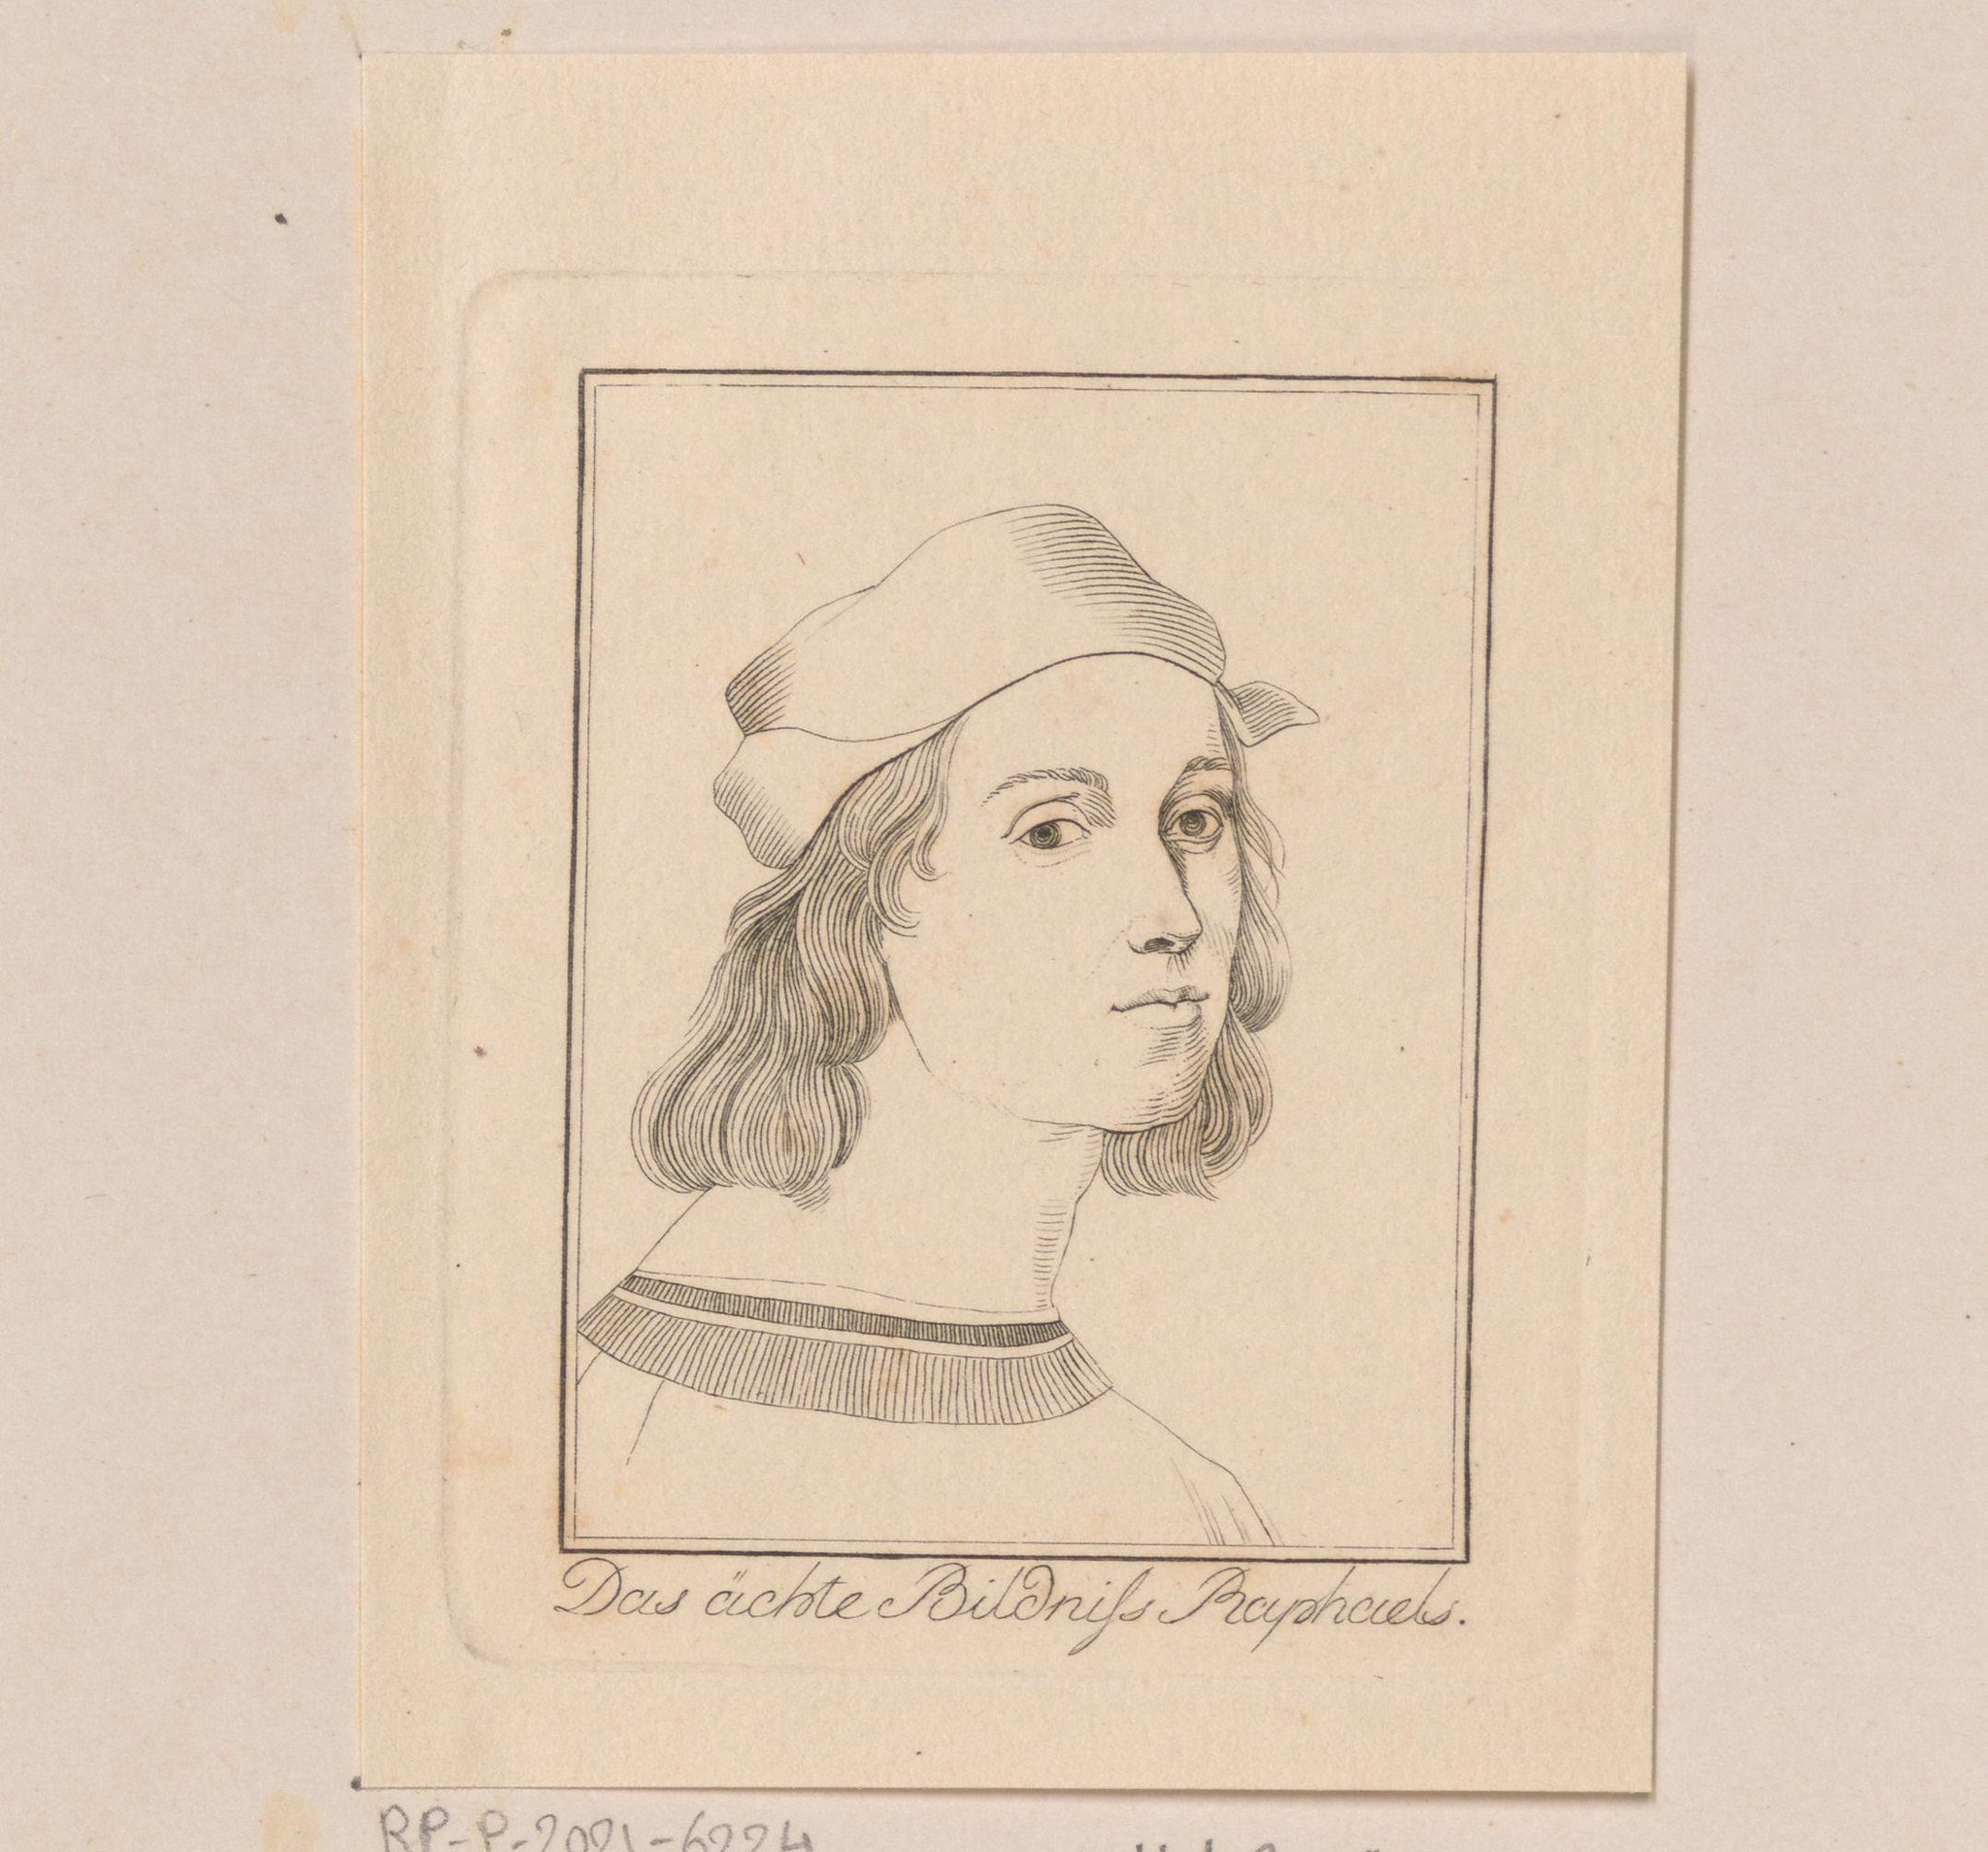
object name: print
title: Portret van Rafaël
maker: Anonymous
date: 1800-1849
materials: paper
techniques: engraving, etching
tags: rafaël, historical persons, portrait, self-portrait of painter